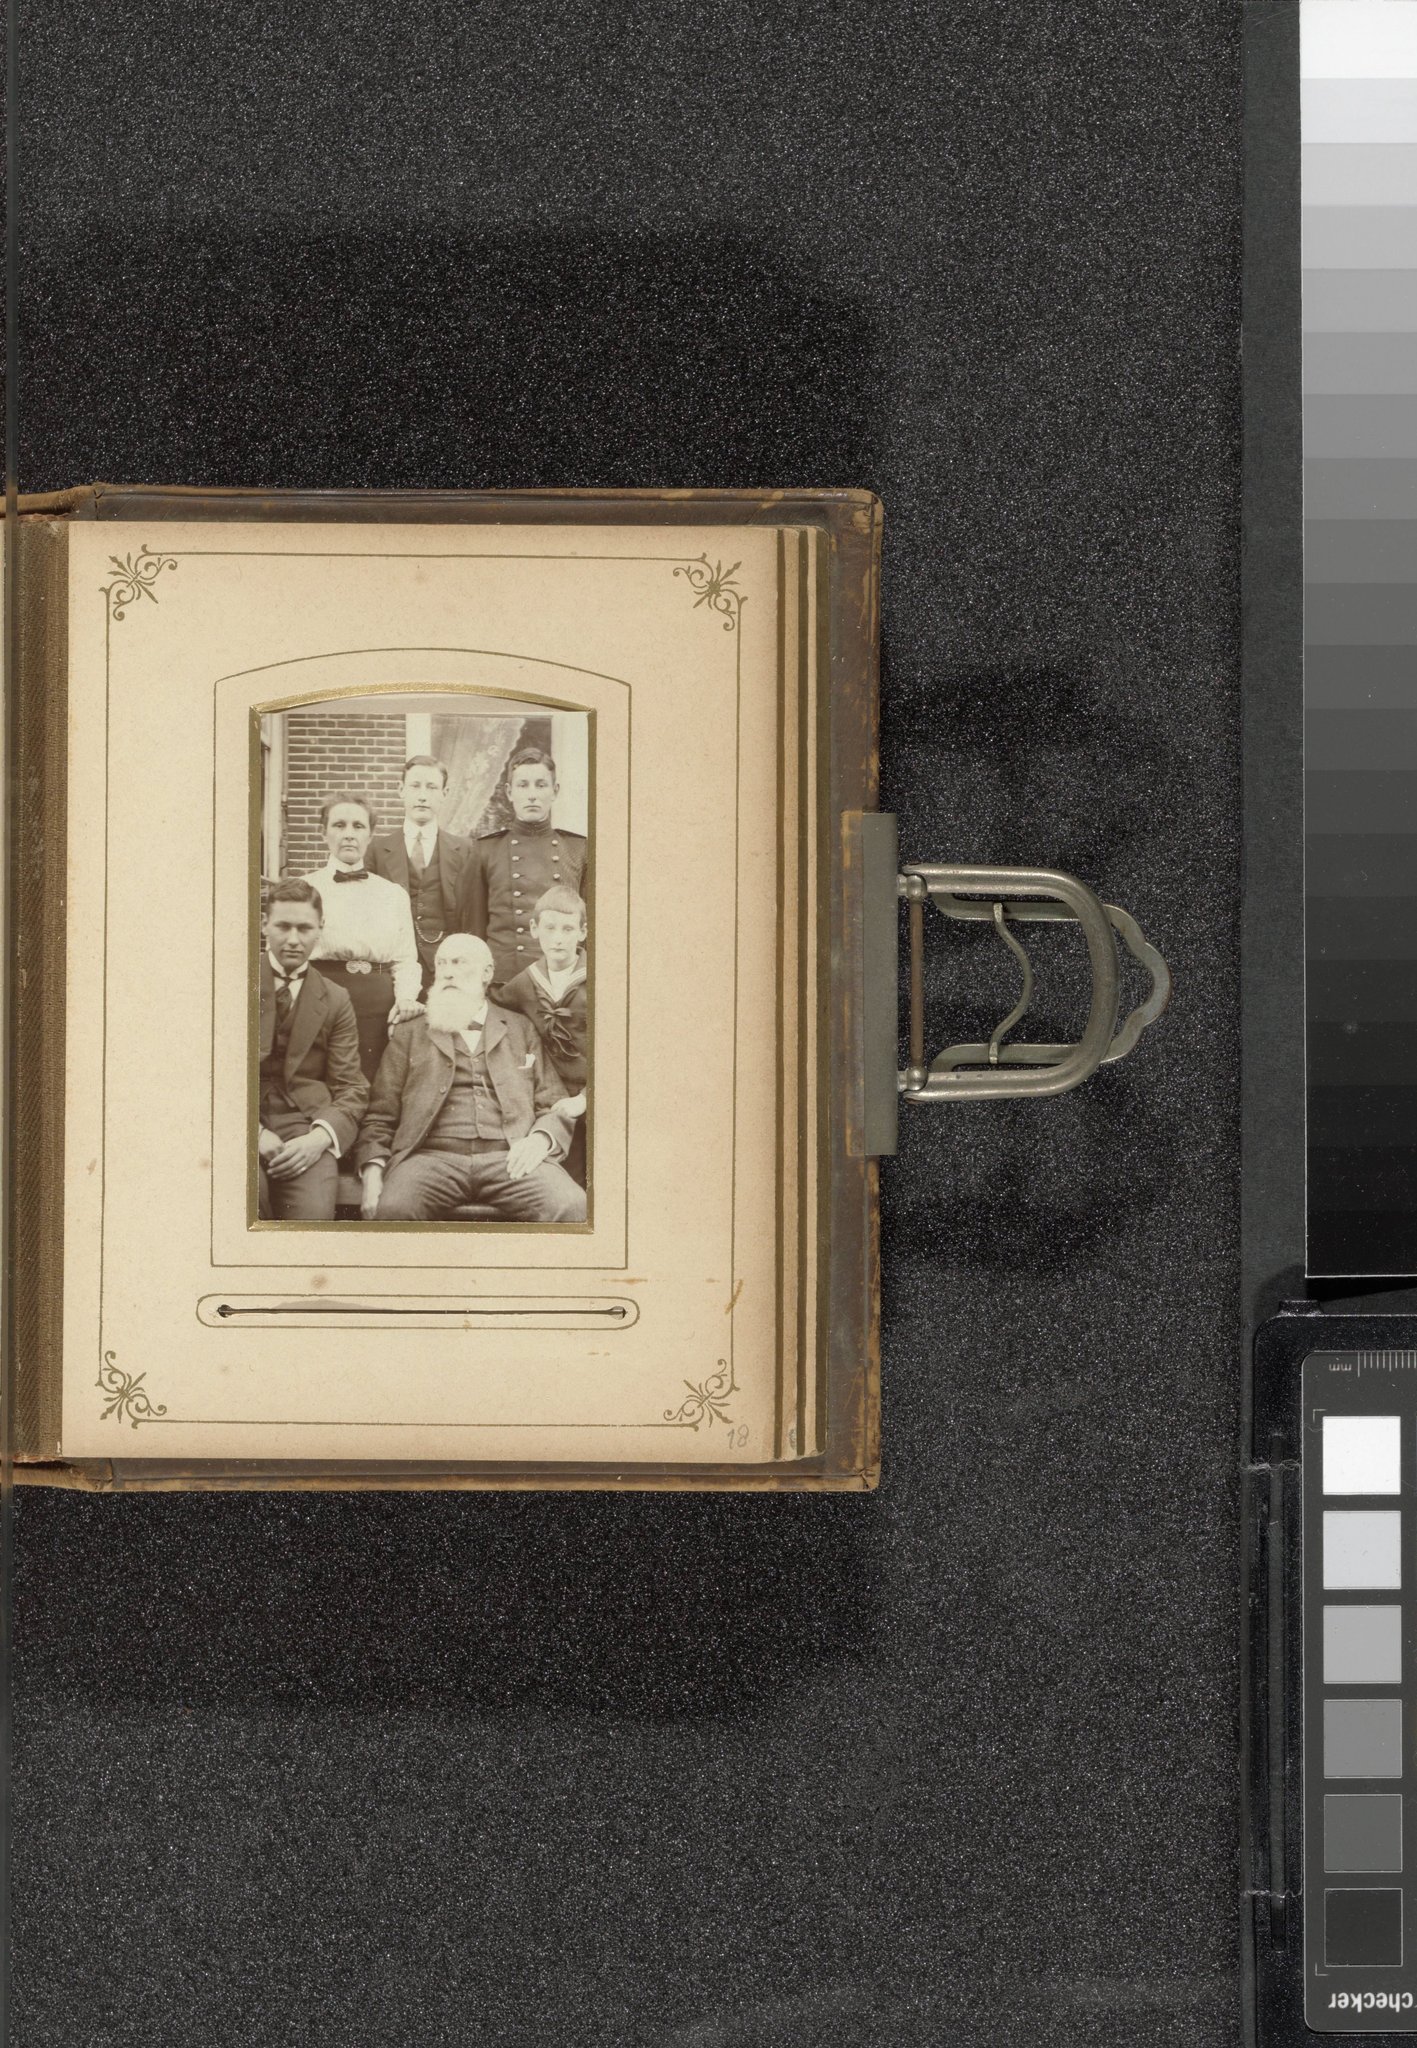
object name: photograph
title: Portret van het gezin van JMK Pennink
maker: Anonymous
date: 1910-1920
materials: cardboard, paper, photographic support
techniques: gelatin silver print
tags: nijmegen, family group, especially parents with their child(ren), historical persons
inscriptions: inscription: ‘[...] vader, Pim, [...]an, Jaap, Frans Pennink’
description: Onderdeel van Fotoalbum van de families Boelen, Matthes en Pennink.